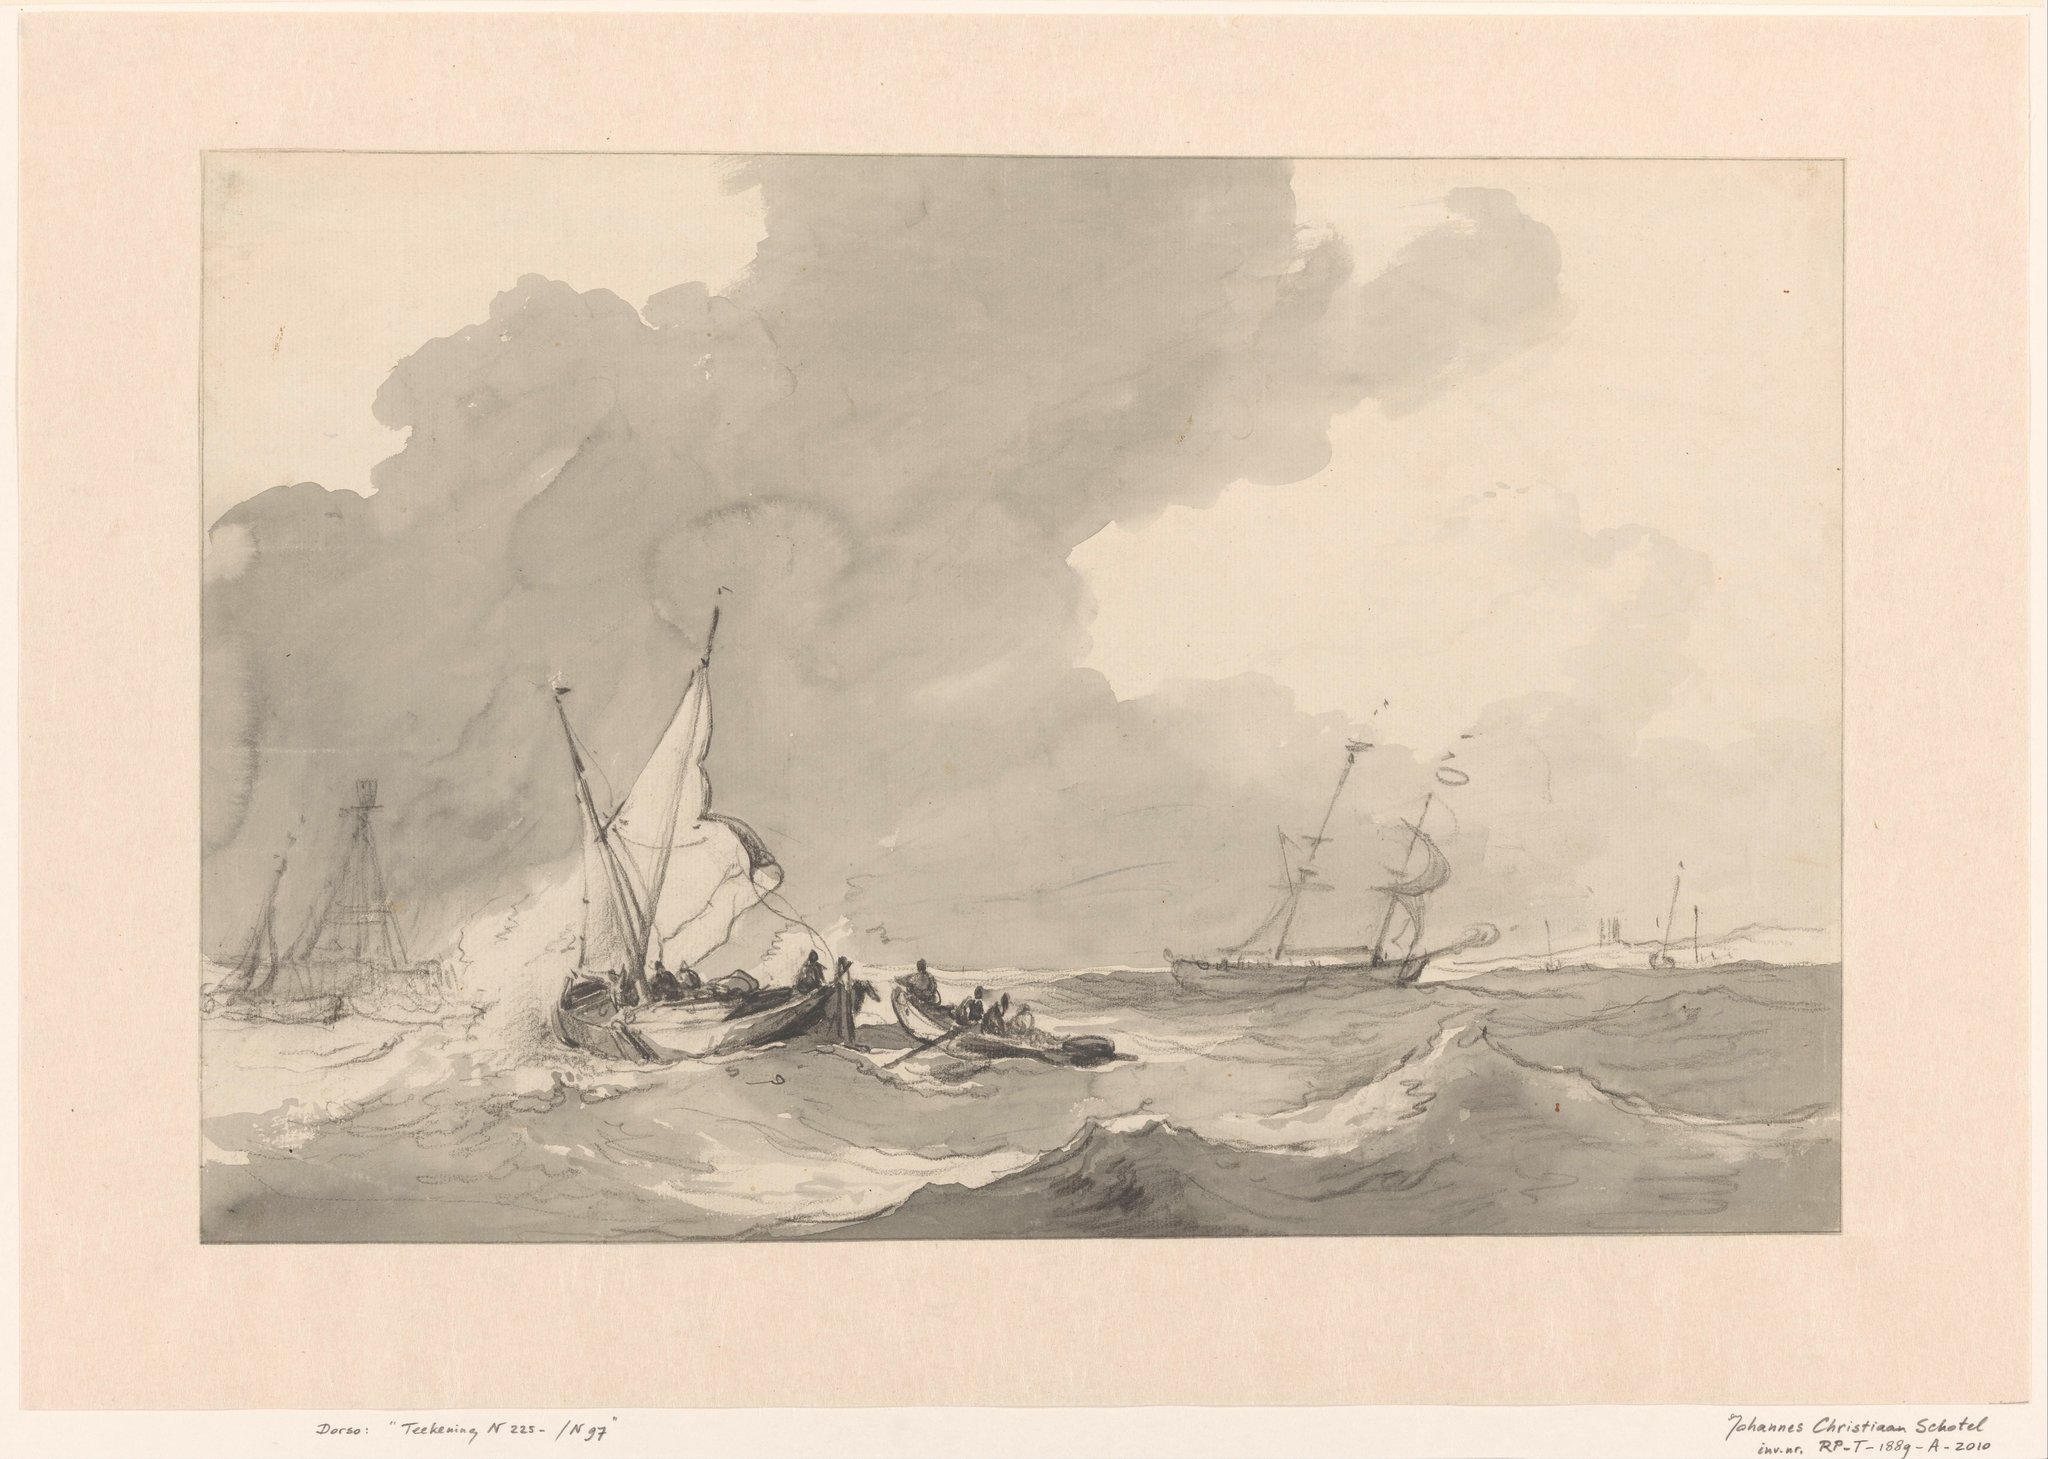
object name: drawing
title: Schepen op een woelige zee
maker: johannes christiaan schotel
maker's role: draughtsman, painter, print maker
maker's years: 1787-1838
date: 1797-1838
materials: chalk, paper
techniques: brush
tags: sailing-ship, sailing-boat, storm at sea